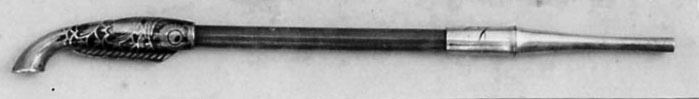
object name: tobacco pipe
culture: japanese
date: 1801-1900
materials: bamboo, brass, silver